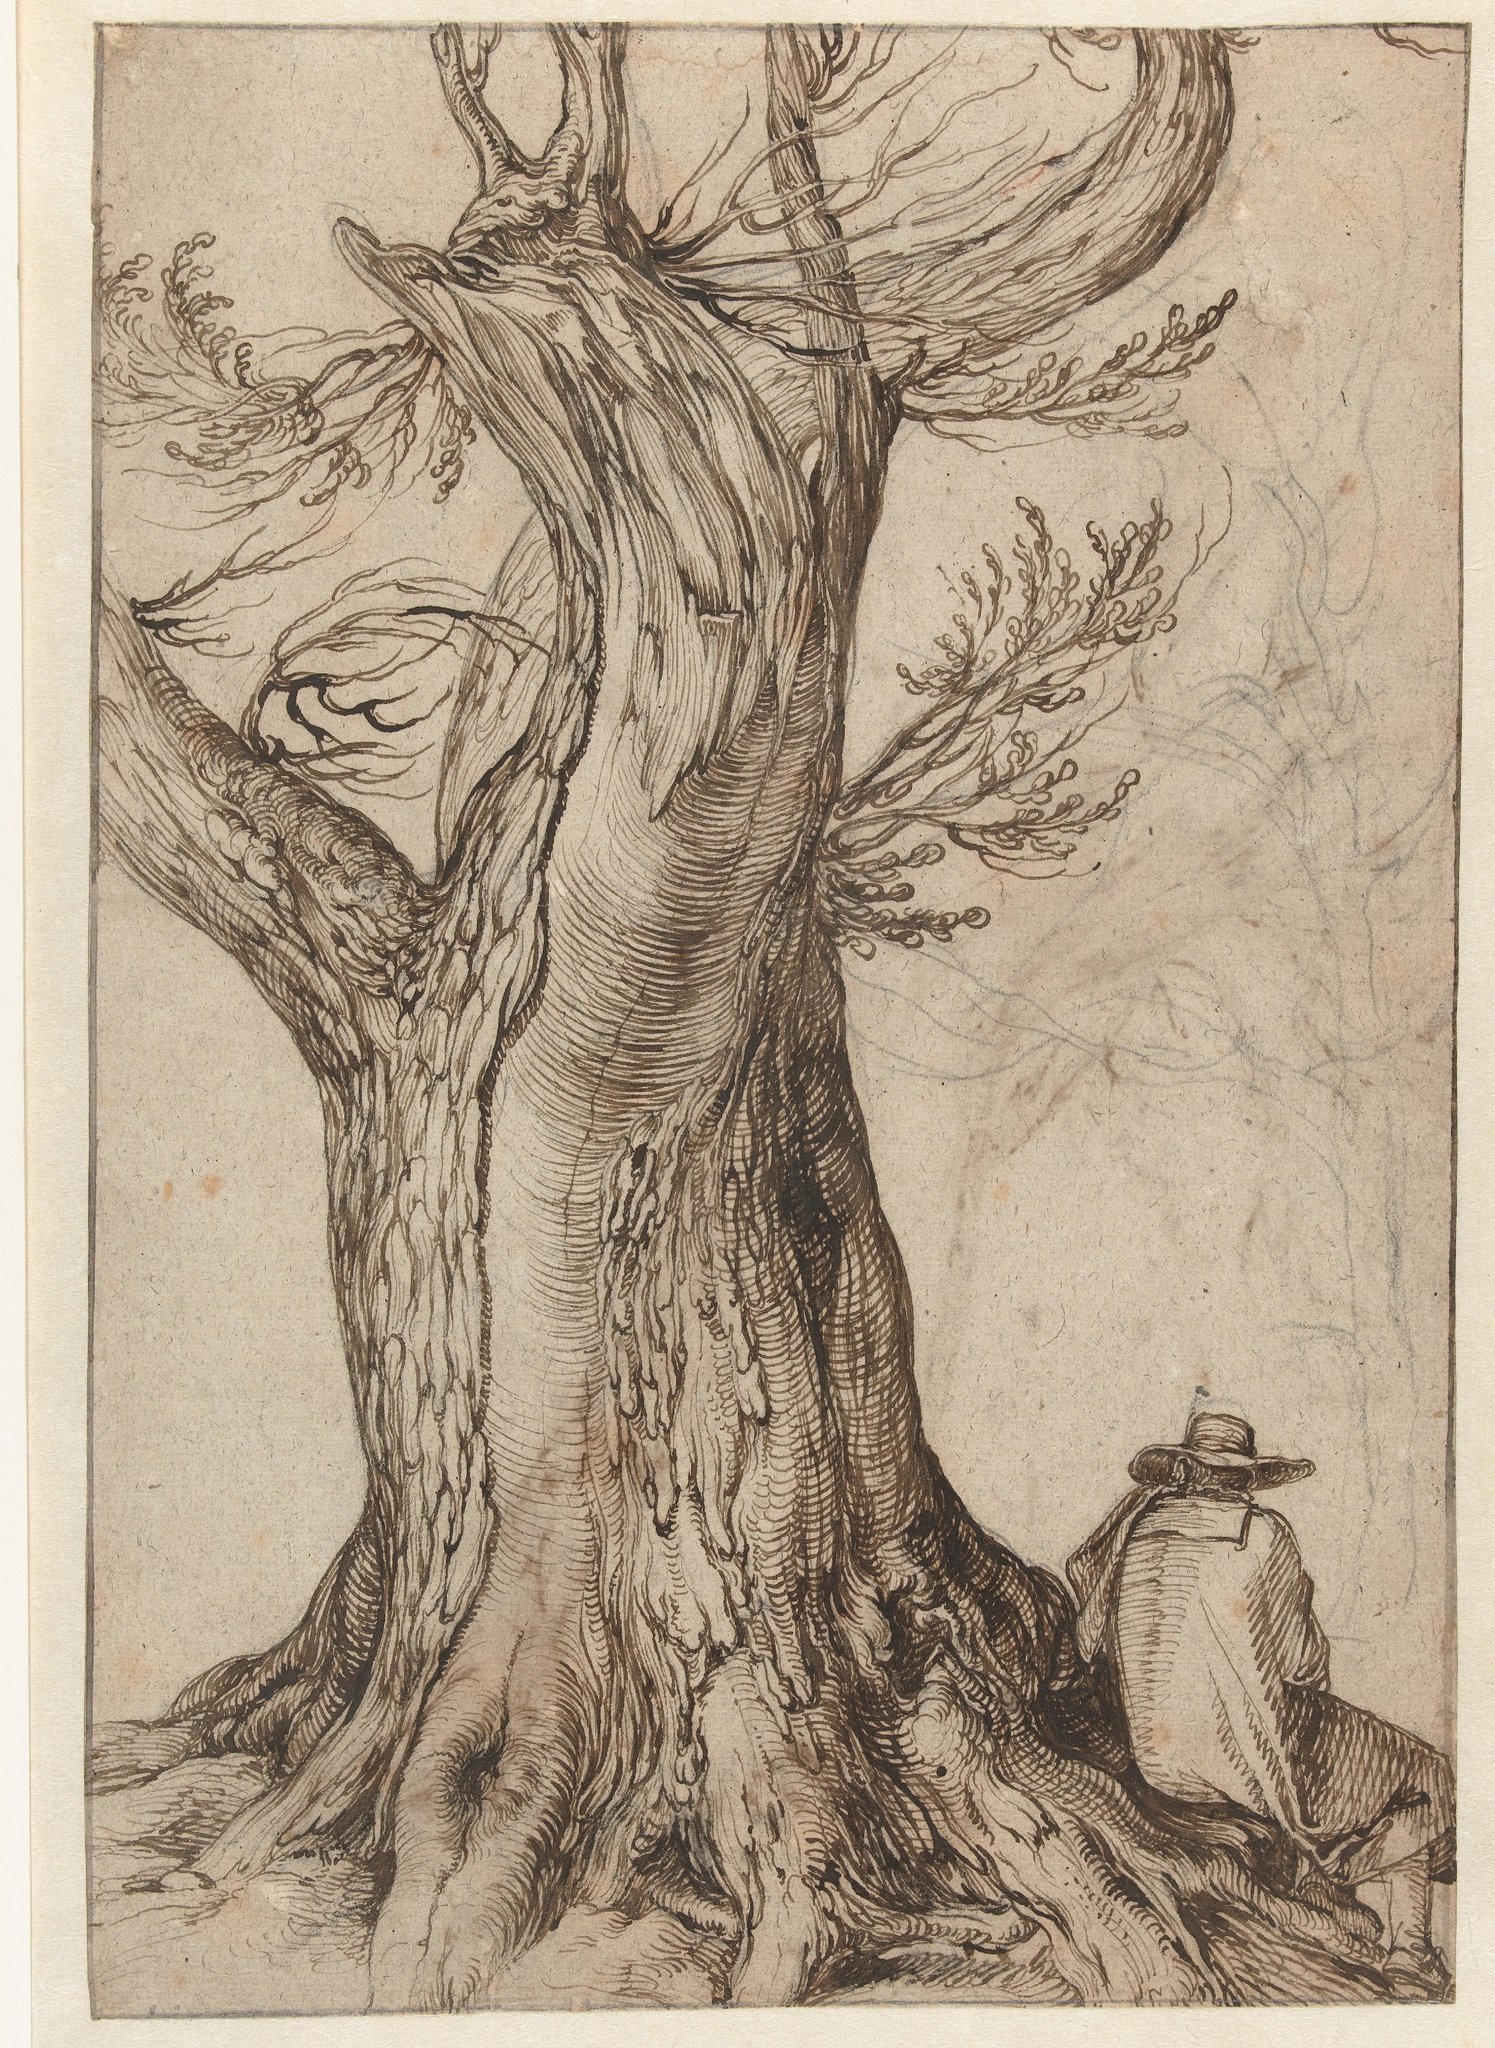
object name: drawing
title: Study of a tree trunk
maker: jacques de gheyn (ii)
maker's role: painter, print maker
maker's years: 1565-1629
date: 1598-1608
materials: paper, chalk, ink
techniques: pen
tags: trees: chestnut-tree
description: Jacques de Gheyn regularly ventured out into nature, taking chalk and paper with him. On one of his walks he recorded the contours of this tree with just a few black chalk lines. Once back in his studio, De Gheyn worked up the sketch further with pen and ink.